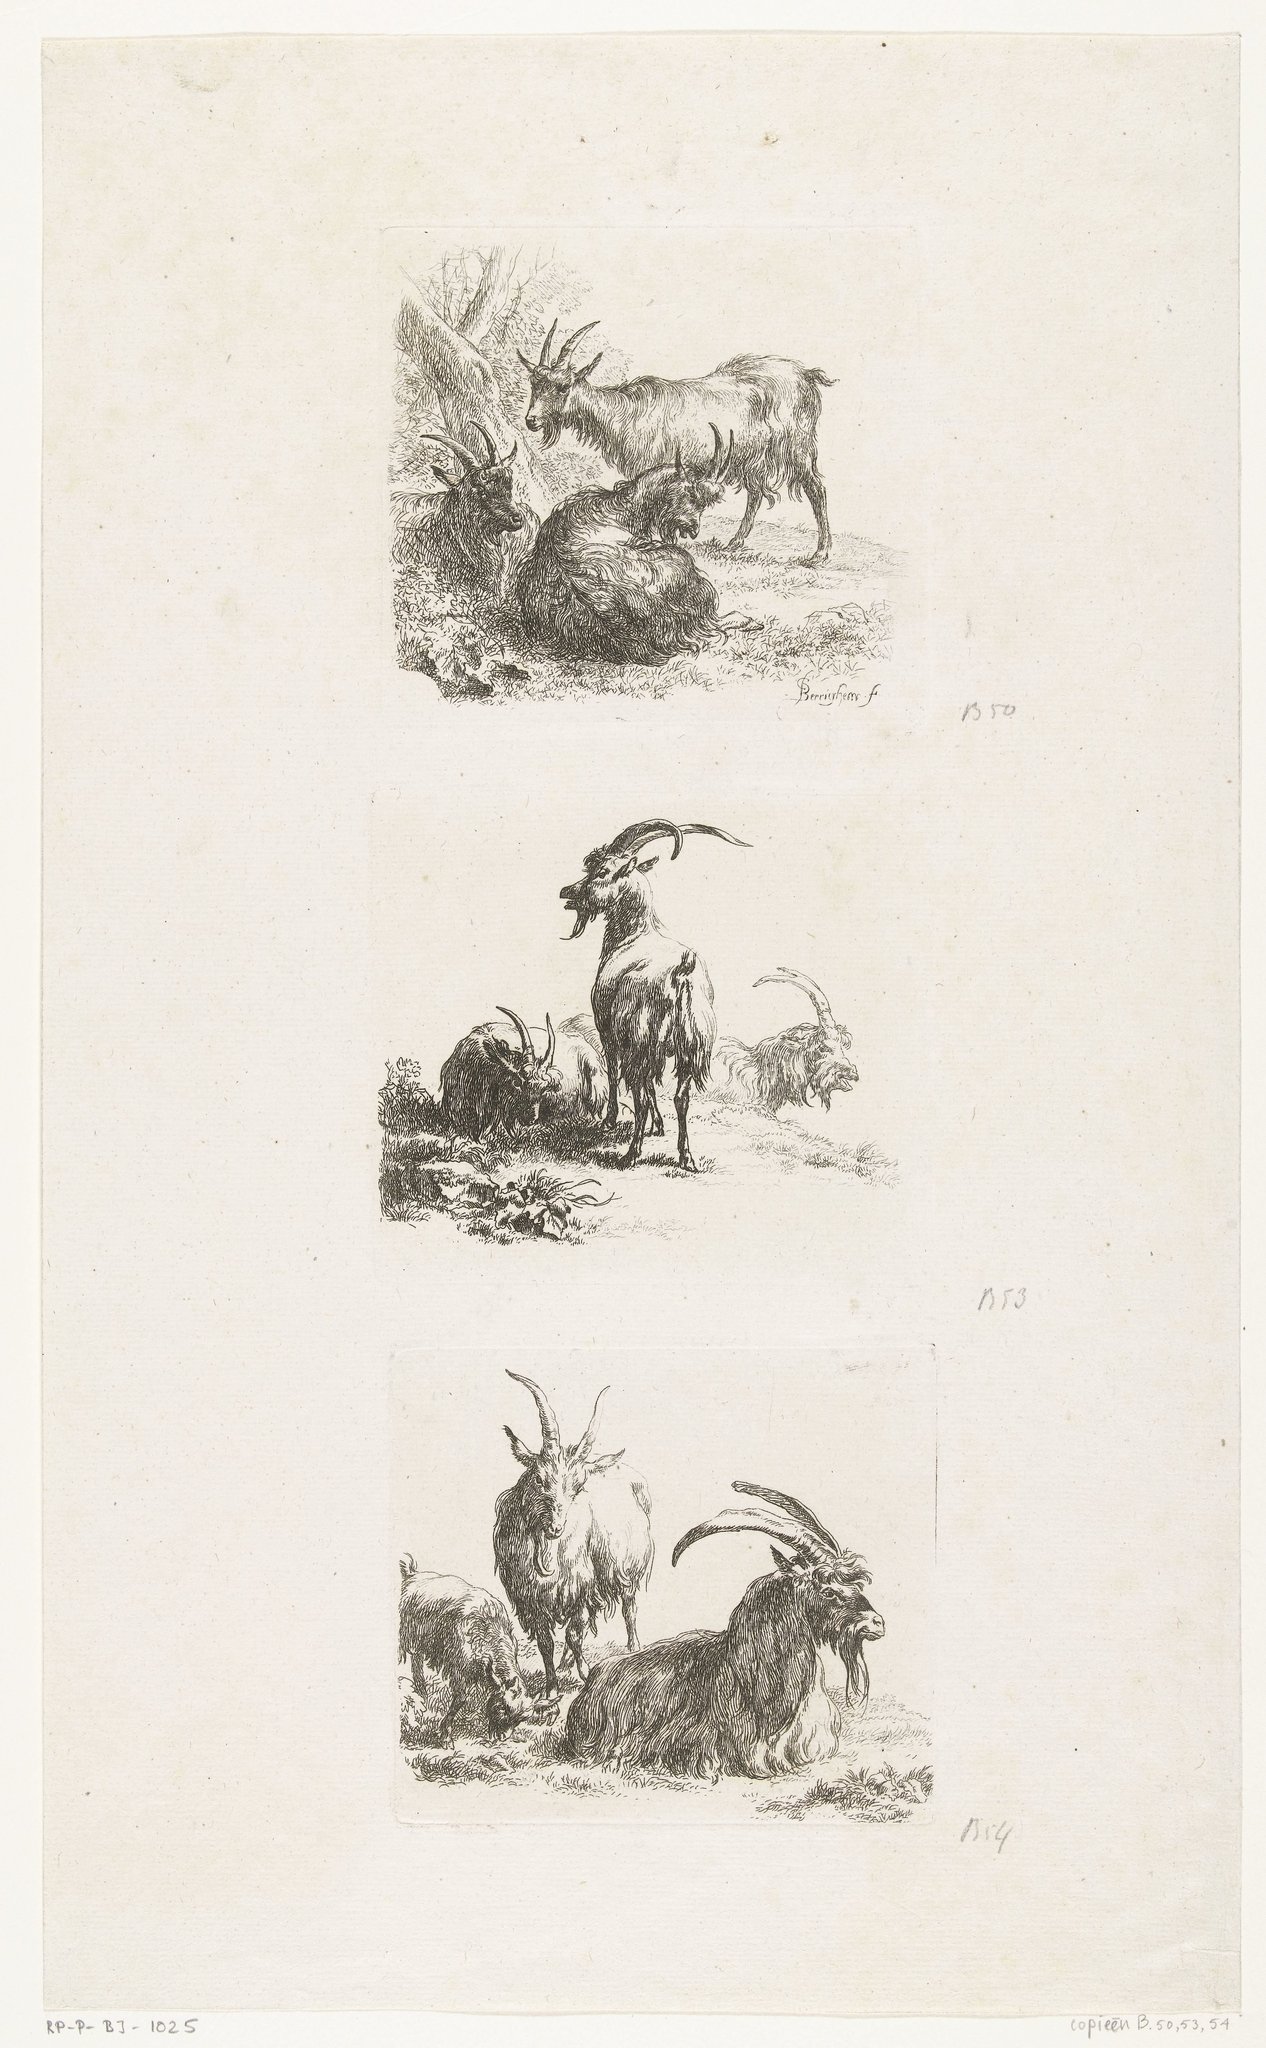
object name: print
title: Animalia ad vivum delineata et aqua forti aeri impressa Studio et Arte Nicolai Berchemi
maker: Anonymous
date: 1648-1733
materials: paper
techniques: etching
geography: netherlands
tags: goat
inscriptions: collector's mark: Lugt 2228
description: Drie prenten uit een serie van acht prenten met verschillende dieren, op een vel papier afgedrukt. Boven drie geiten, in het midden drie bokken, onder een liggende bok en een geit met een bokje.